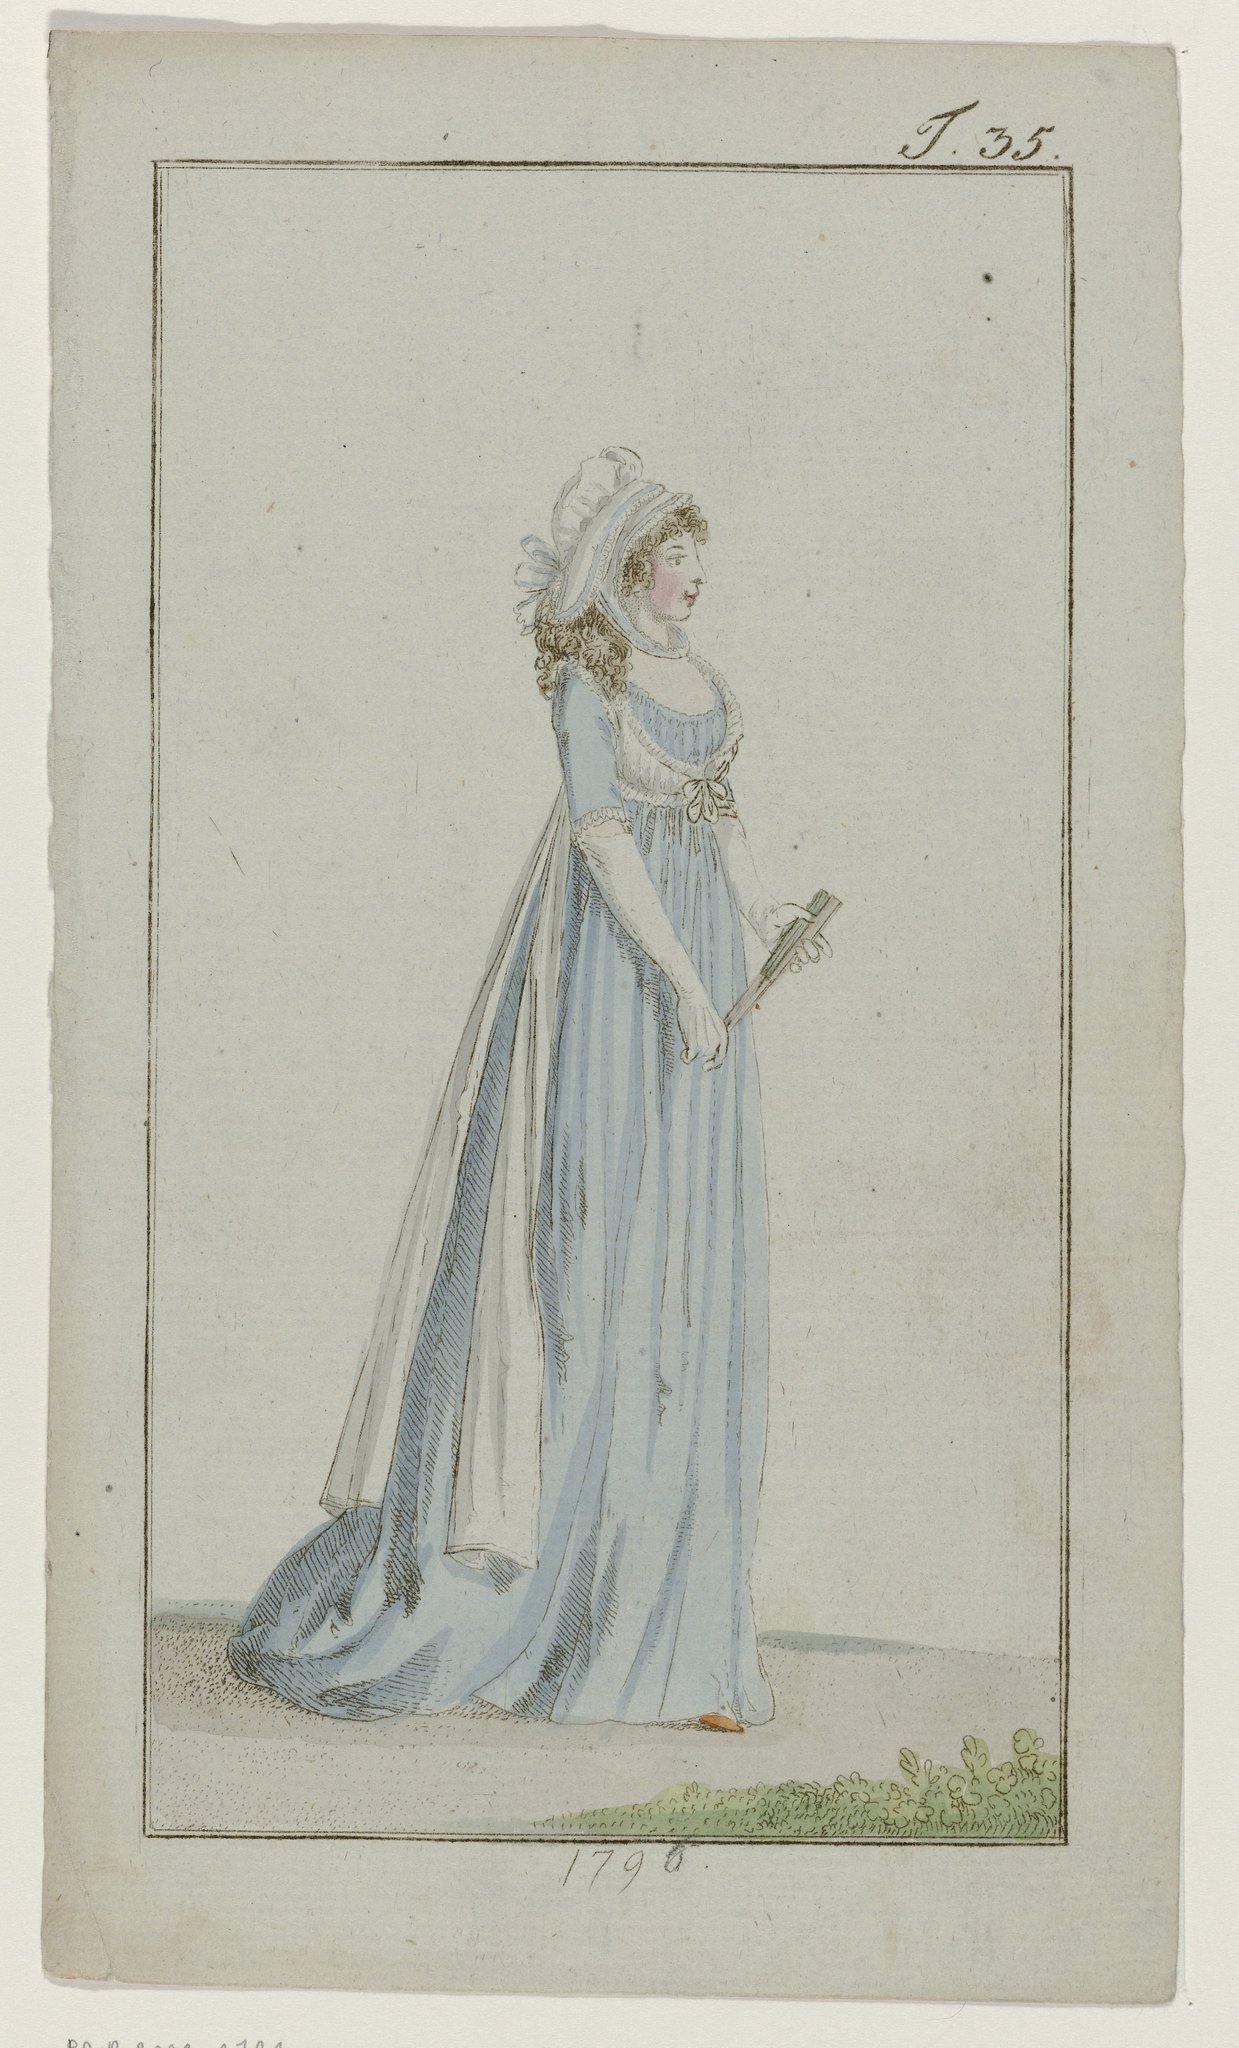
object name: fashion print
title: Journal des Luxus und der Moden, 1796, T 35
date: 1796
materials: paper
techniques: etching, hand coloring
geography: weimar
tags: clothing for the upper part of the body (+ women's clothes), gloves, mittens (long gloves) (+ women's clothes), head-gear: cap (+ women's clothes), fashion plates, dress, gown (+ women's clothes), fan (+ women's clothes)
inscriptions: date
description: Vrouw in een japon met halflange mouwen, hoge taille en sleep. Accessoires: muts afgezet met een bies in contrasterende kleur, lange handschoenen, waaier. Prent uit het modetijdschrift Journal des Luxus und der Moden, uitgegeven door Friedrich Justin Bertuch en Georg Melchior Kraus, Weimar, 1786-1826.